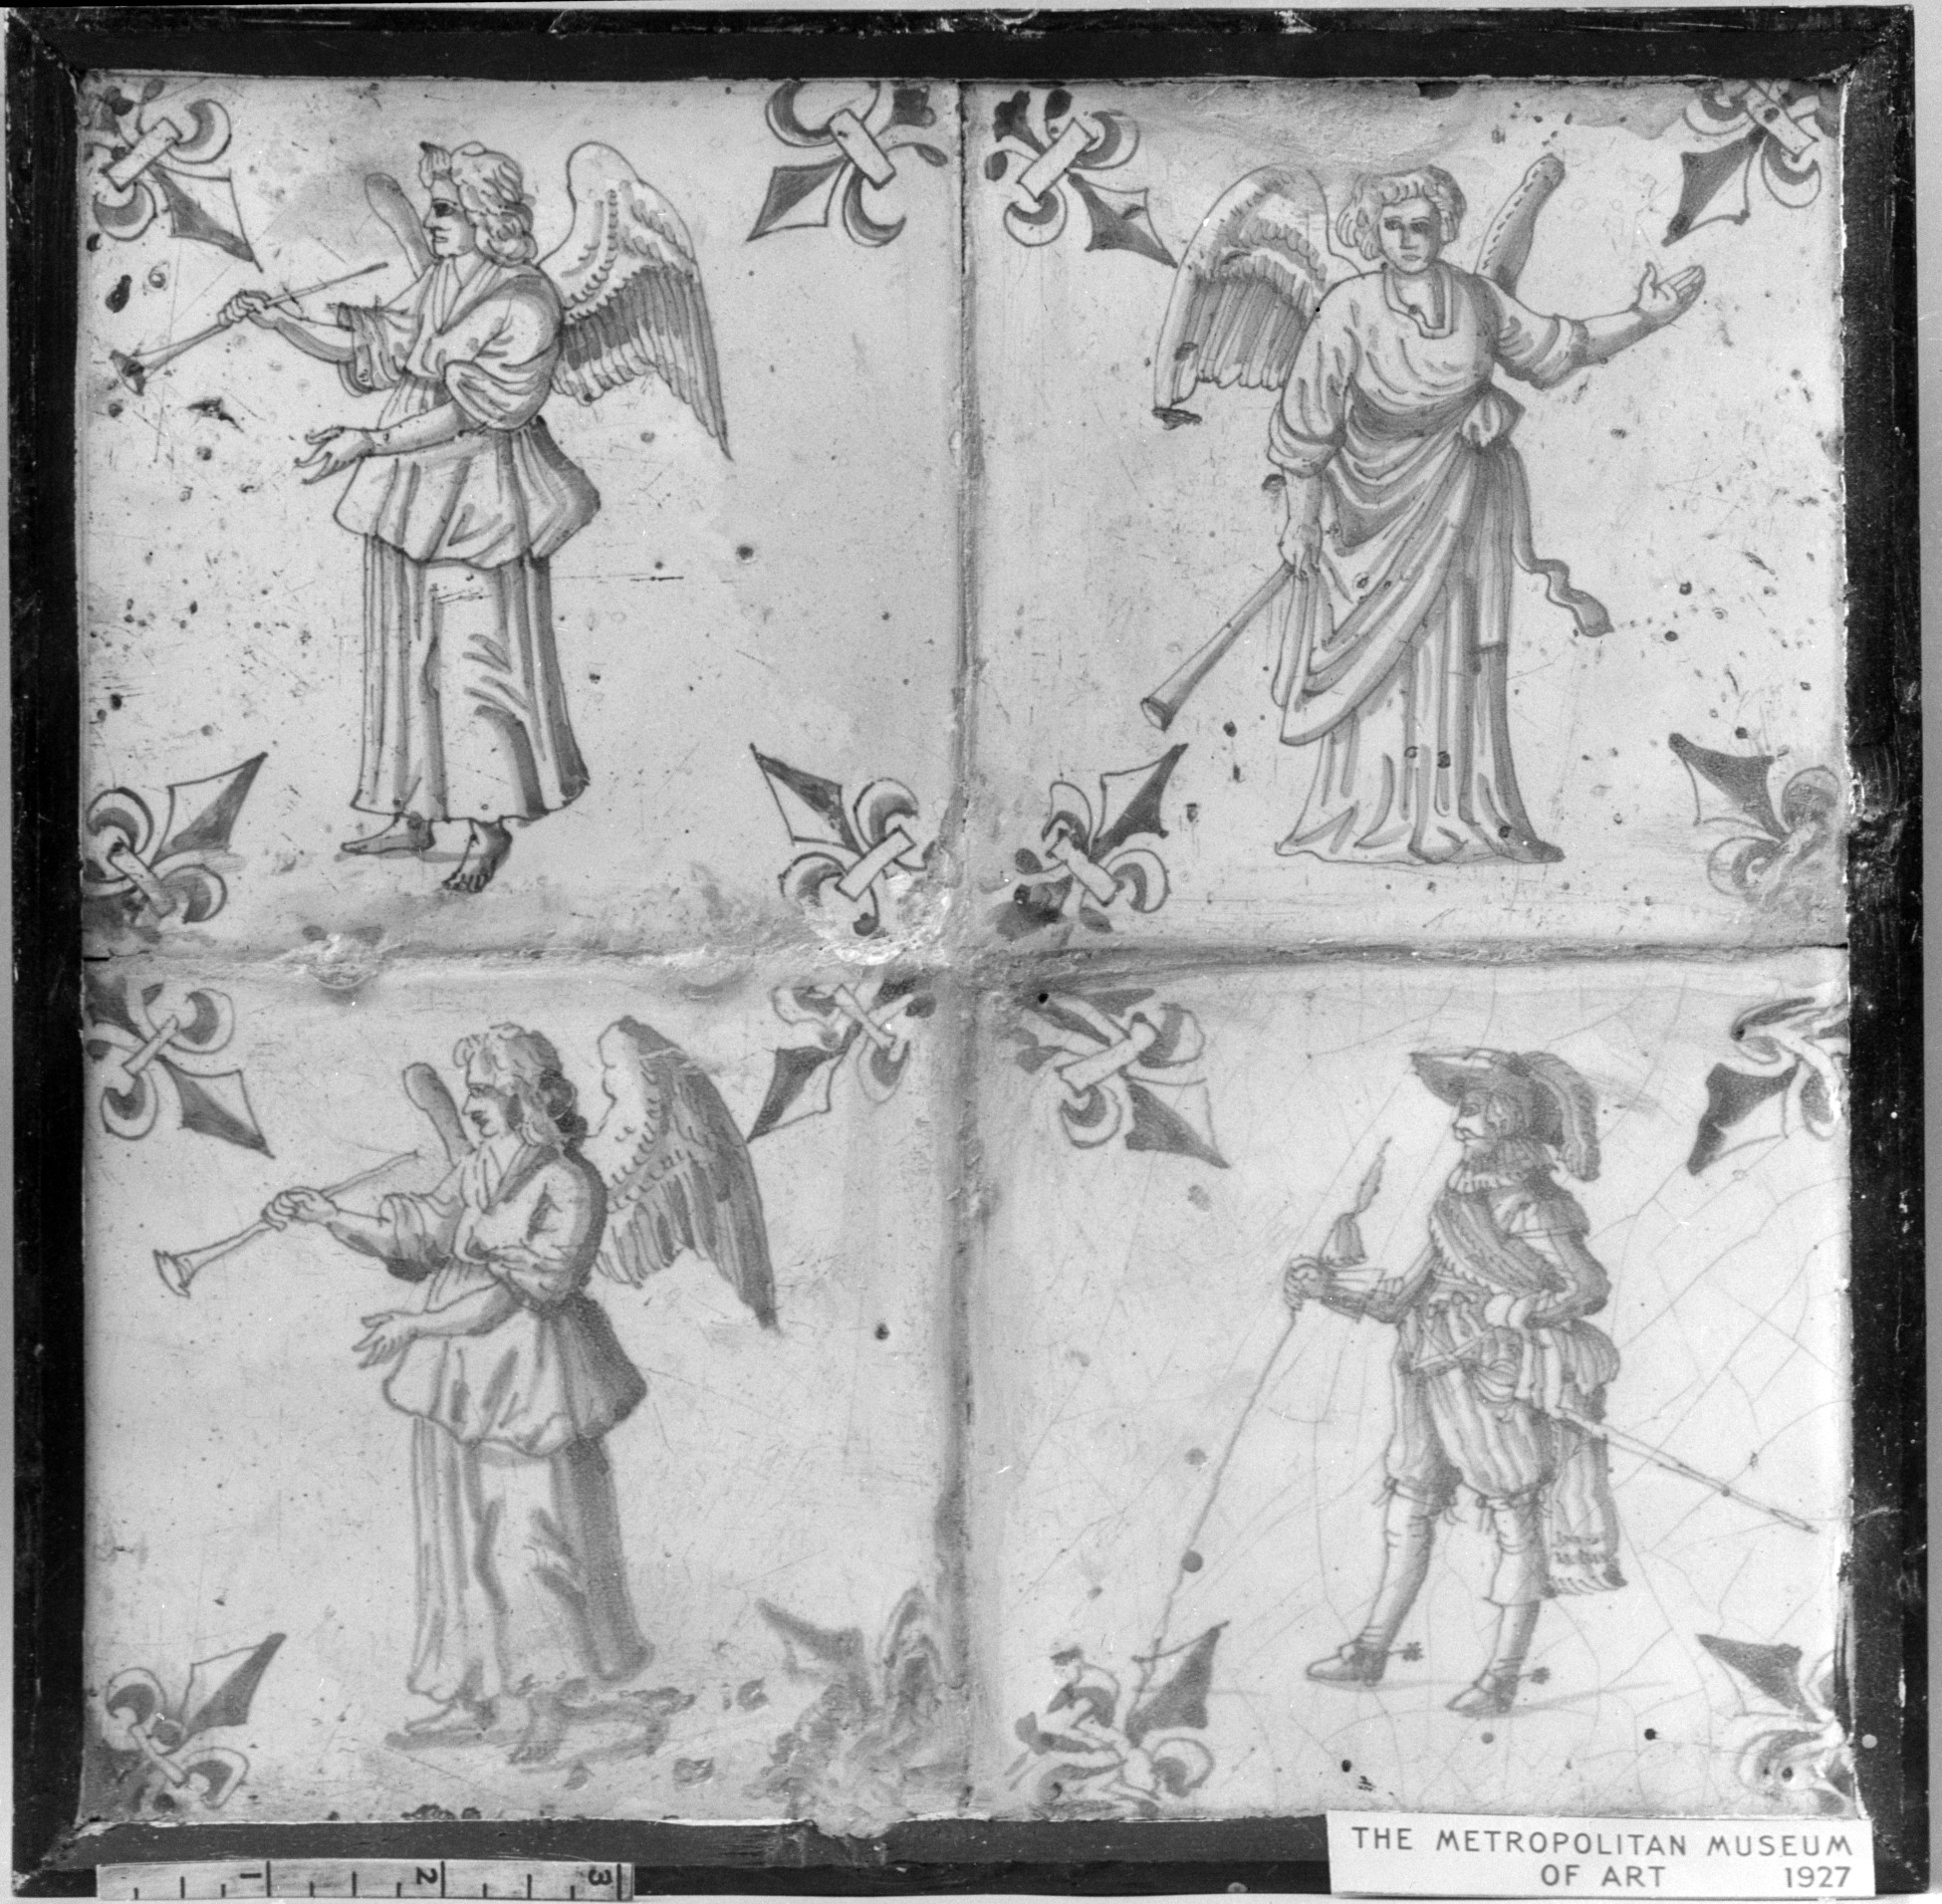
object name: tile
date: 1640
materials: earthenware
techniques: glazing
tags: musical instruments,men,angels